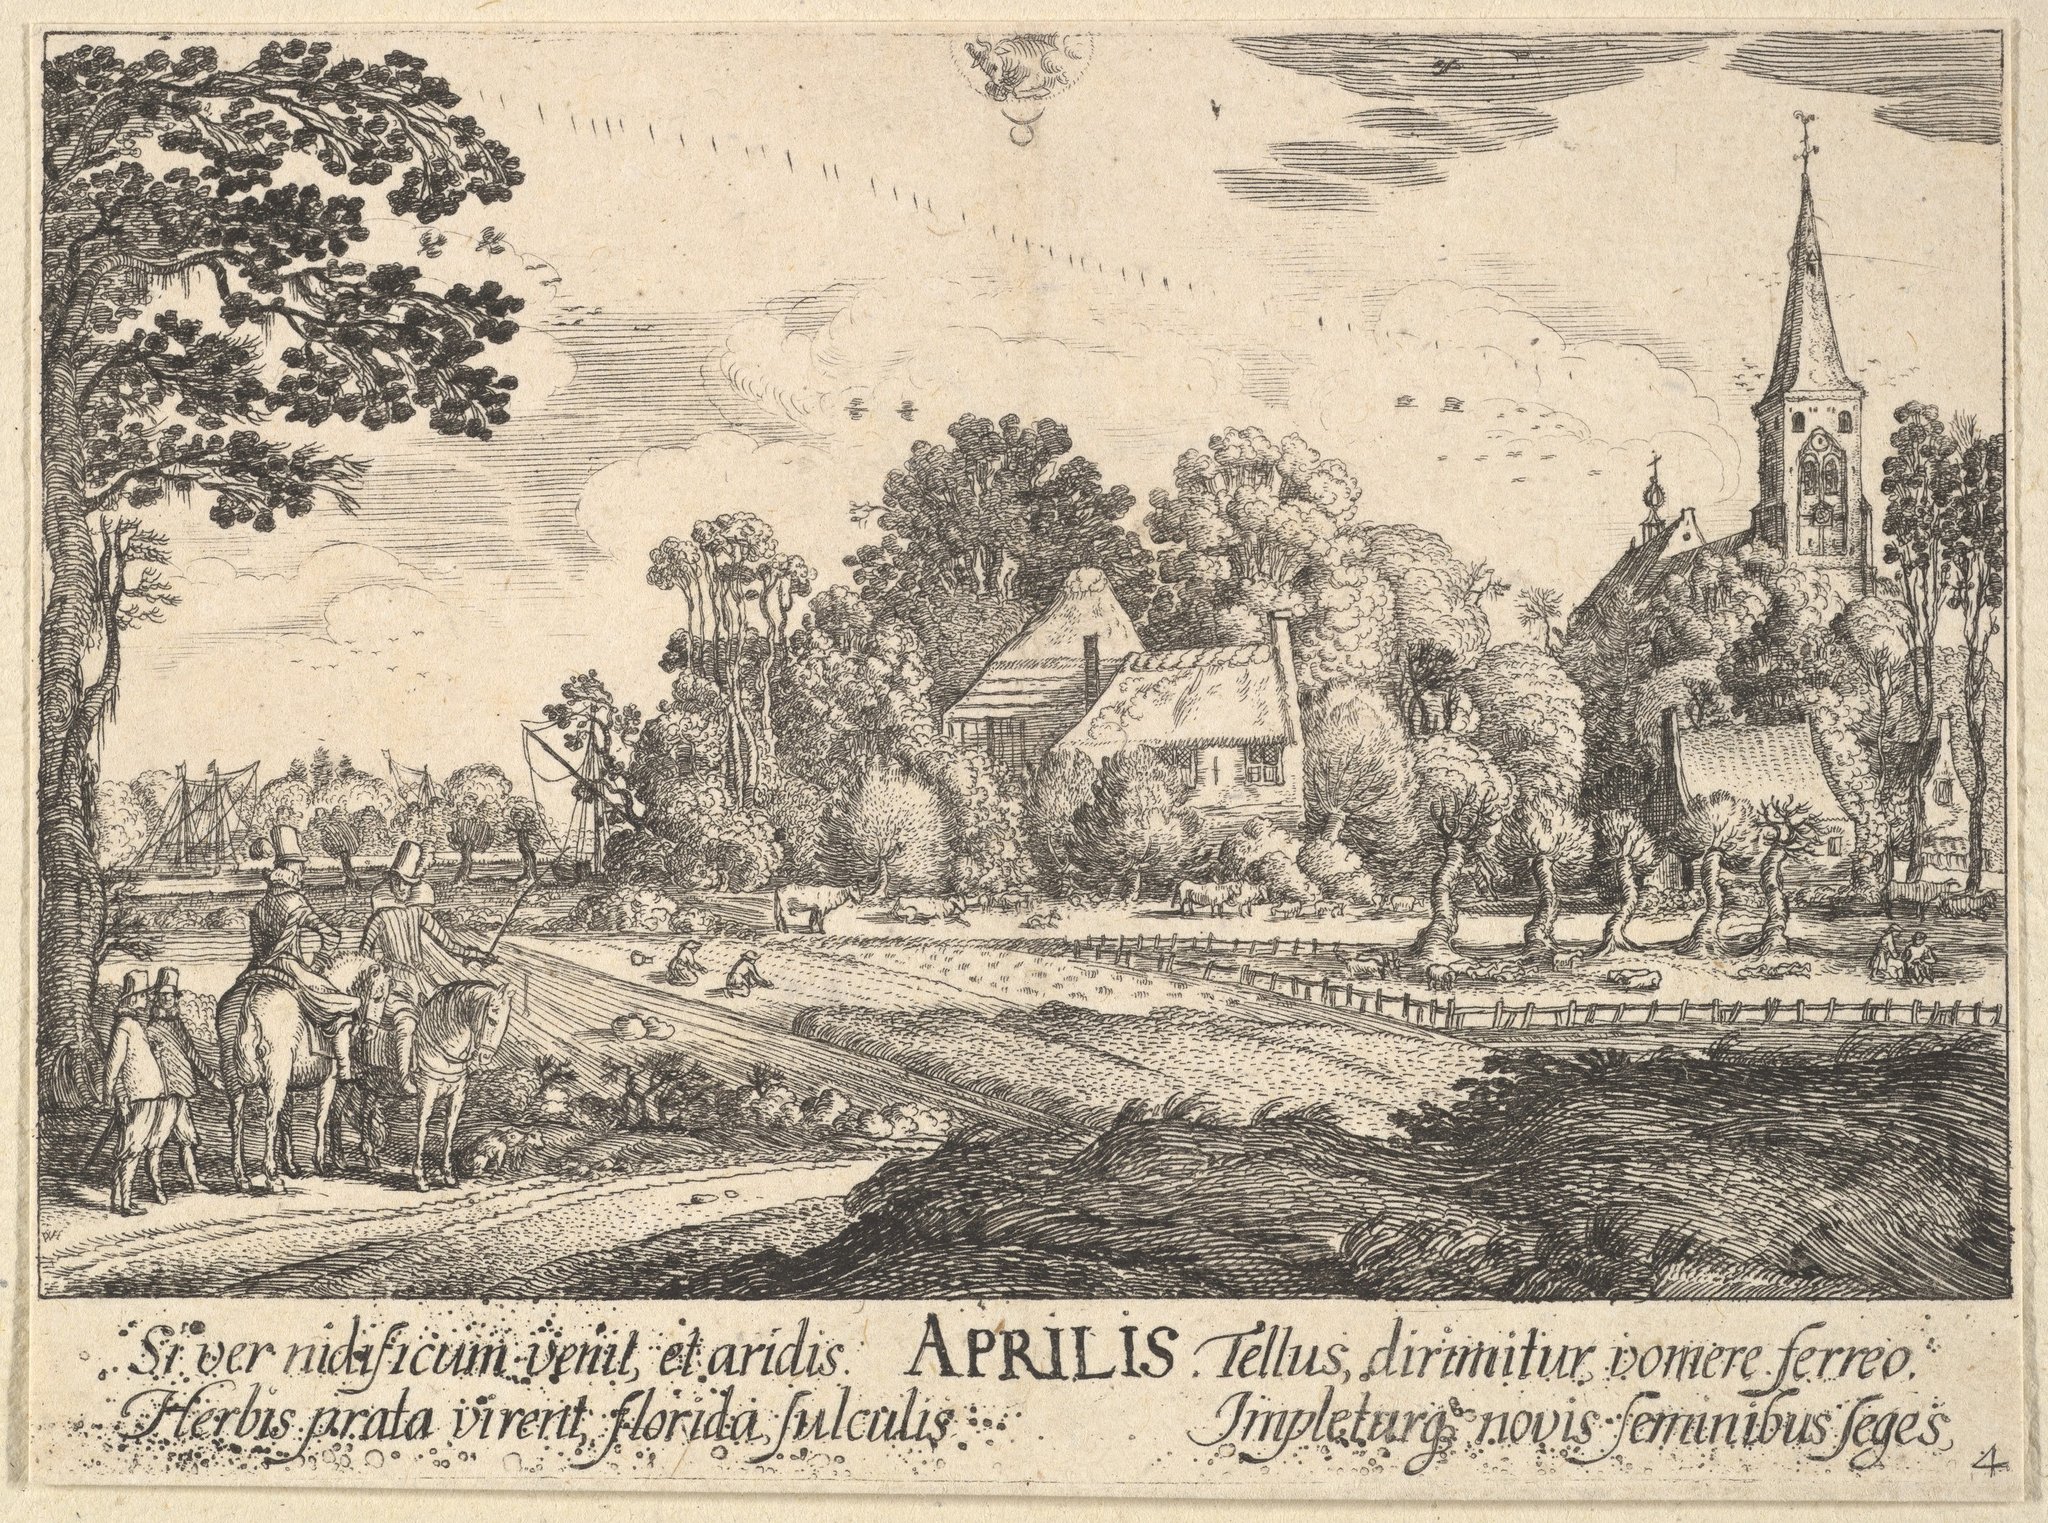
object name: print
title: April (Aprills)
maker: wenceslaus hollar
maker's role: artist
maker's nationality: bohemian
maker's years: 1607-1677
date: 1628-1629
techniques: etching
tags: human figures,buildings,horses,trees